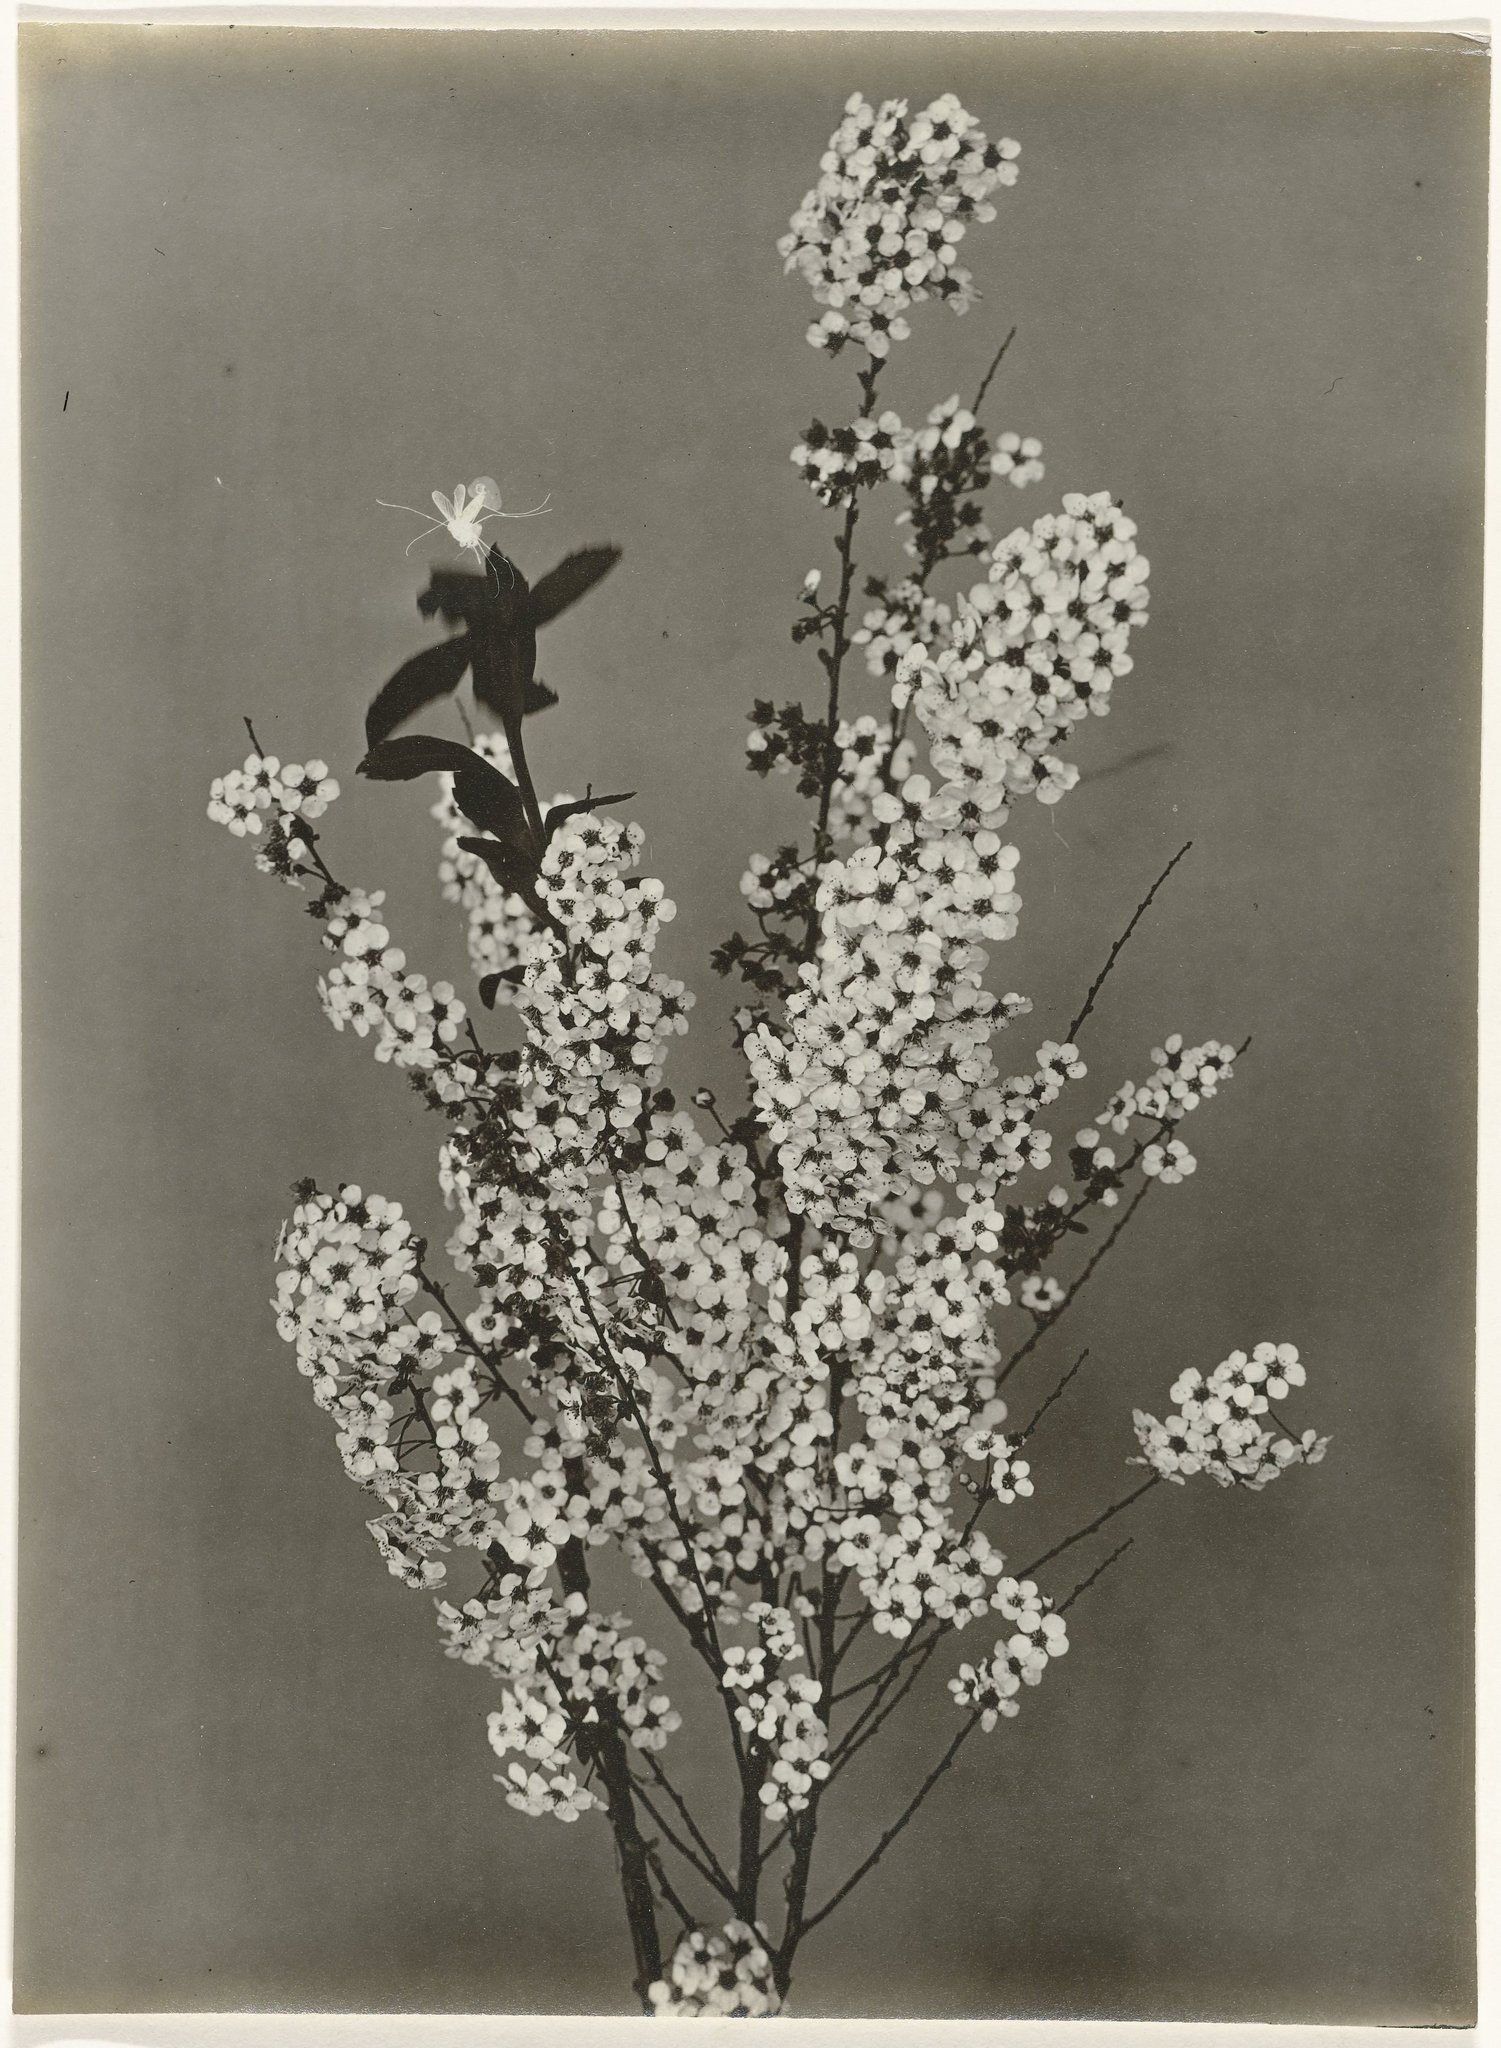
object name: photograph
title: Bloeiende takken, Spiraea Arguta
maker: richard tepe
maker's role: fotograaf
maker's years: 1864-1952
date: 1900-1940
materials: photographic support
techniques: gelatin silver print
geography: netherlands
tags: flowers: spiraea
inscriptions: : ‘Spiraea arguta / bloeiende takken’, : ‘F-14’, signature: ‘foto / R. Tepe’